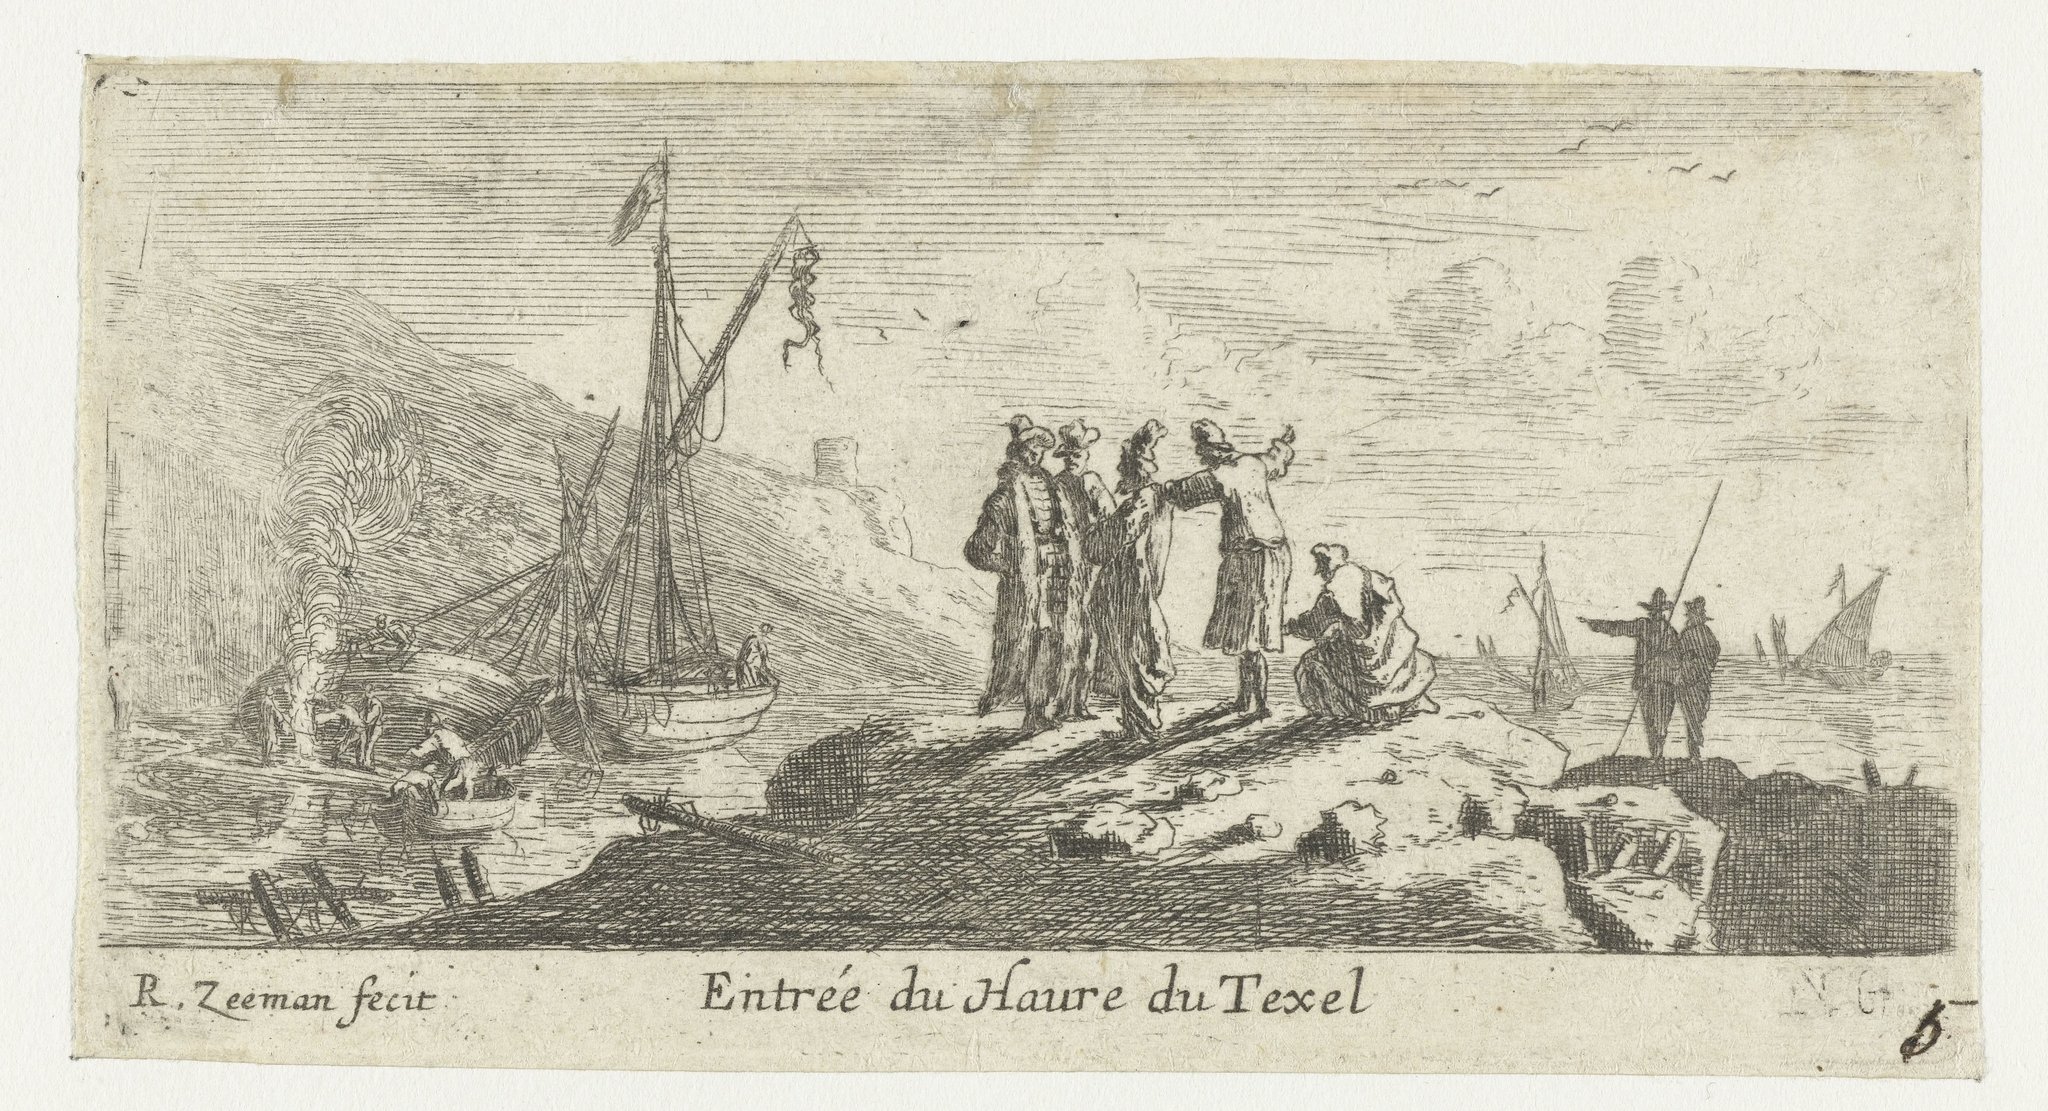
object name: print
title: Ingang van de rede van Texel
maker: reinier nooms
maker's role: draughtsman, painter, print maker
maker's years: 1623-1664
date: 1650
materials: paper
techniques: etching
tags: harbour, repairing, caulking, careening (~ ship)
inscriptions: number: ‘5’, collector's mark: Lugt 1967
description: De ingang van de rede, een natuurlijke ankerplaats voor schepen, bij Texel. In het water wordt een schip gerepareerd, op de wal staat een groep mannen.